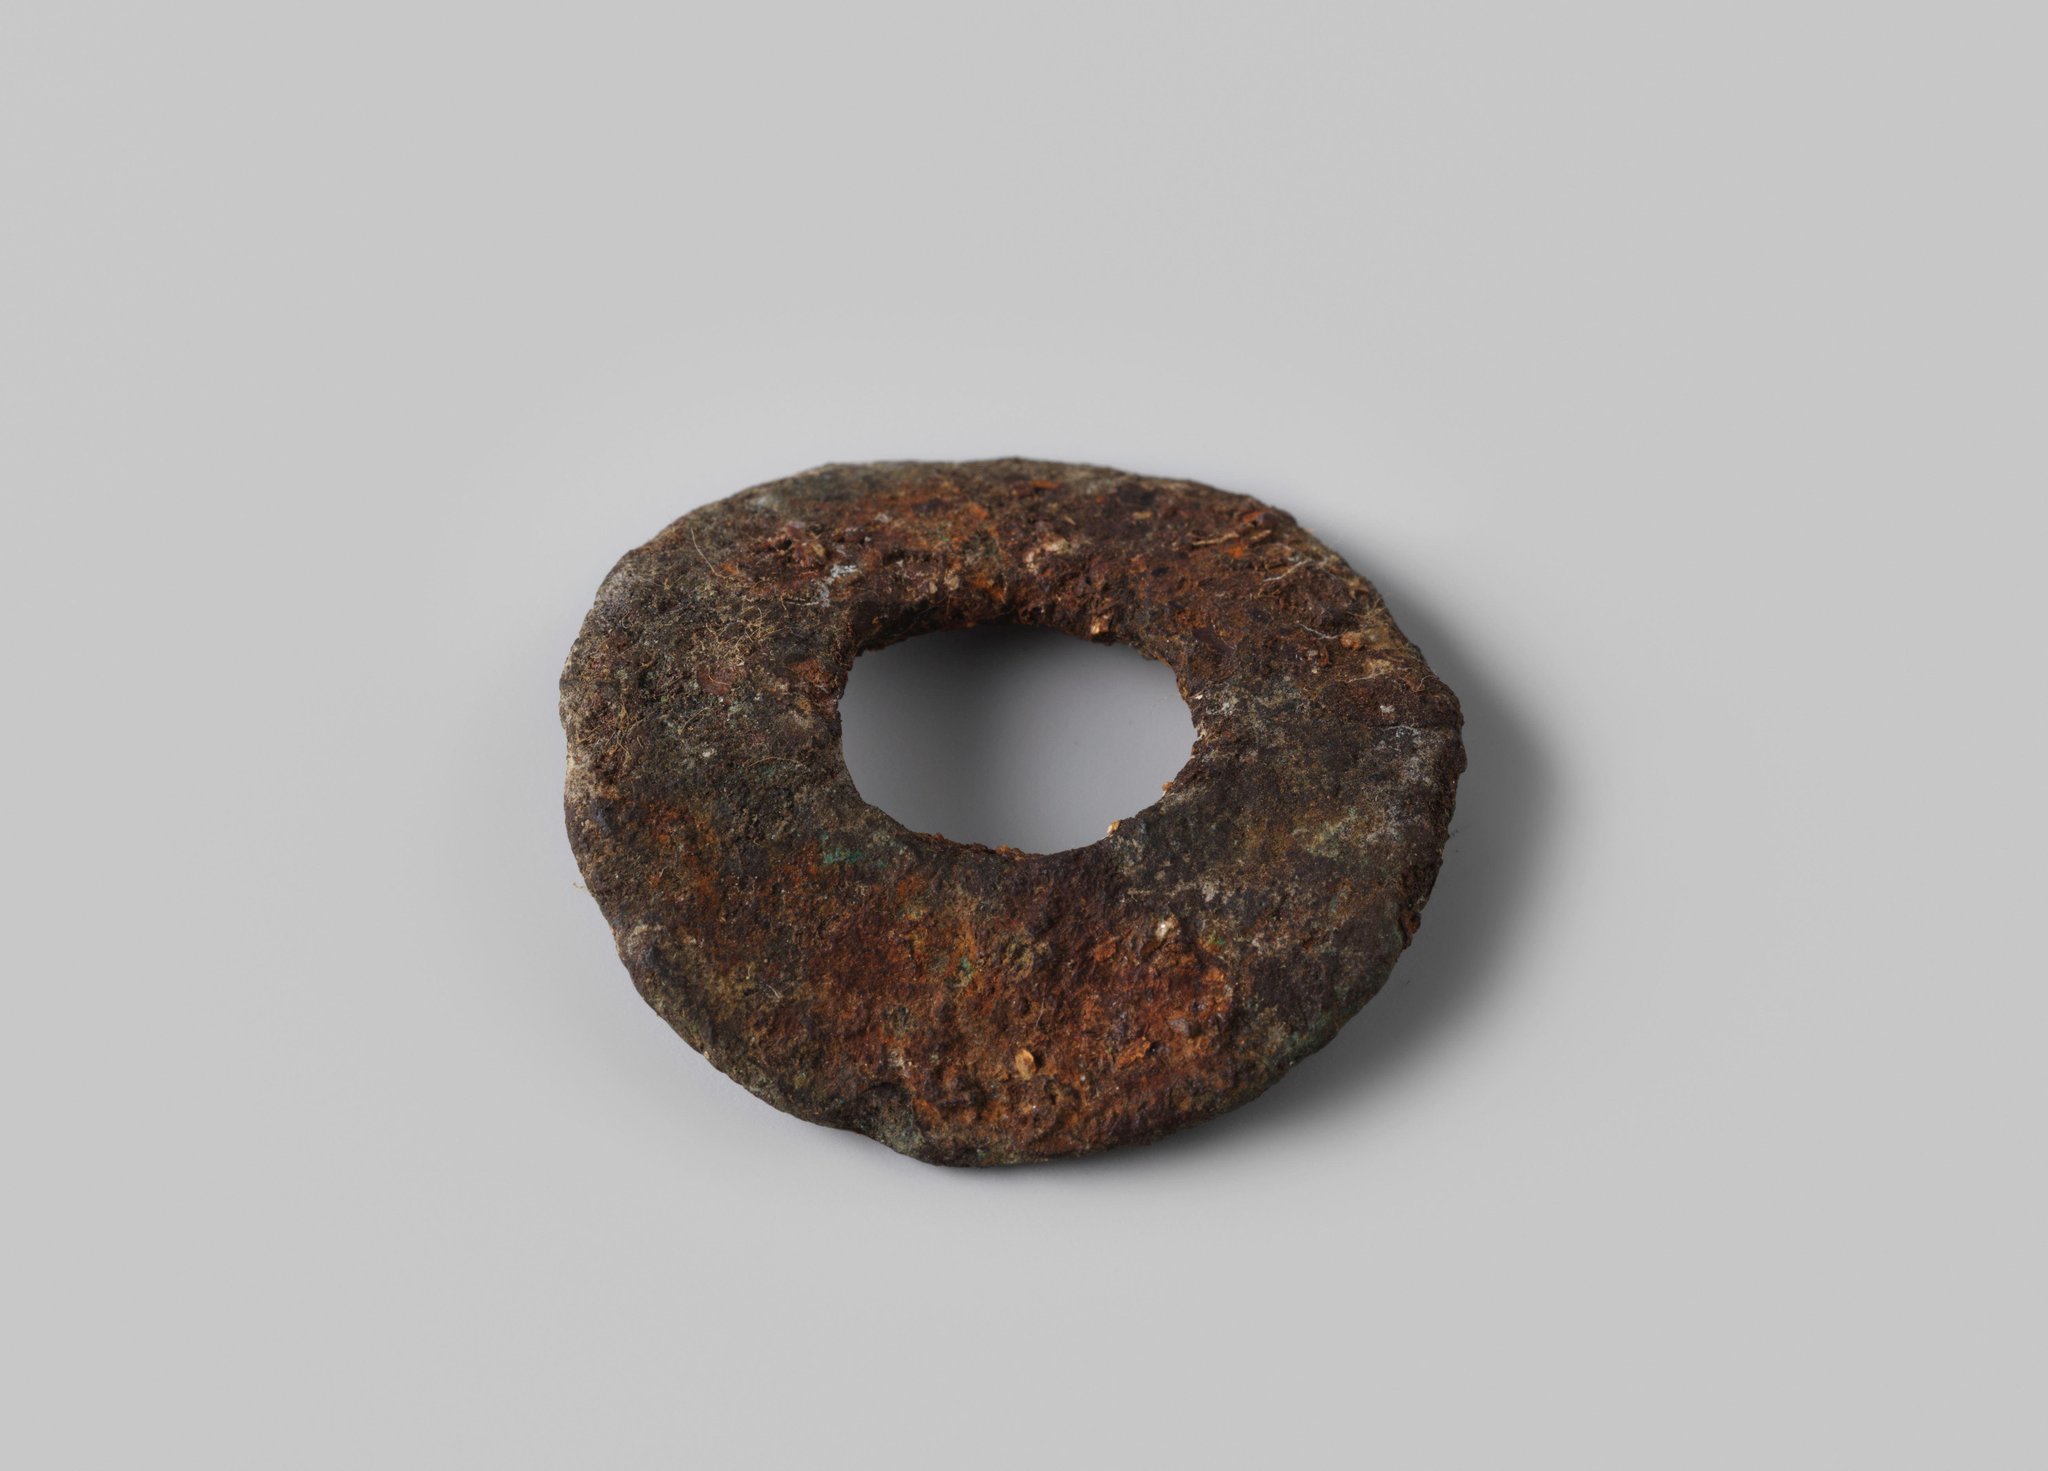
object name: sluitring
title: Sluitring uit het wrak van de Oost-Indiëvaarder Hollandia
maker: Anonymous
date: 1700-1743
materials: copper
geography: netherlands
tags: verenigde oostindische compagnie, hollandia (schip), annet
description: Varied parts or fragments, washers; corroded, squashed, id. 80H163.